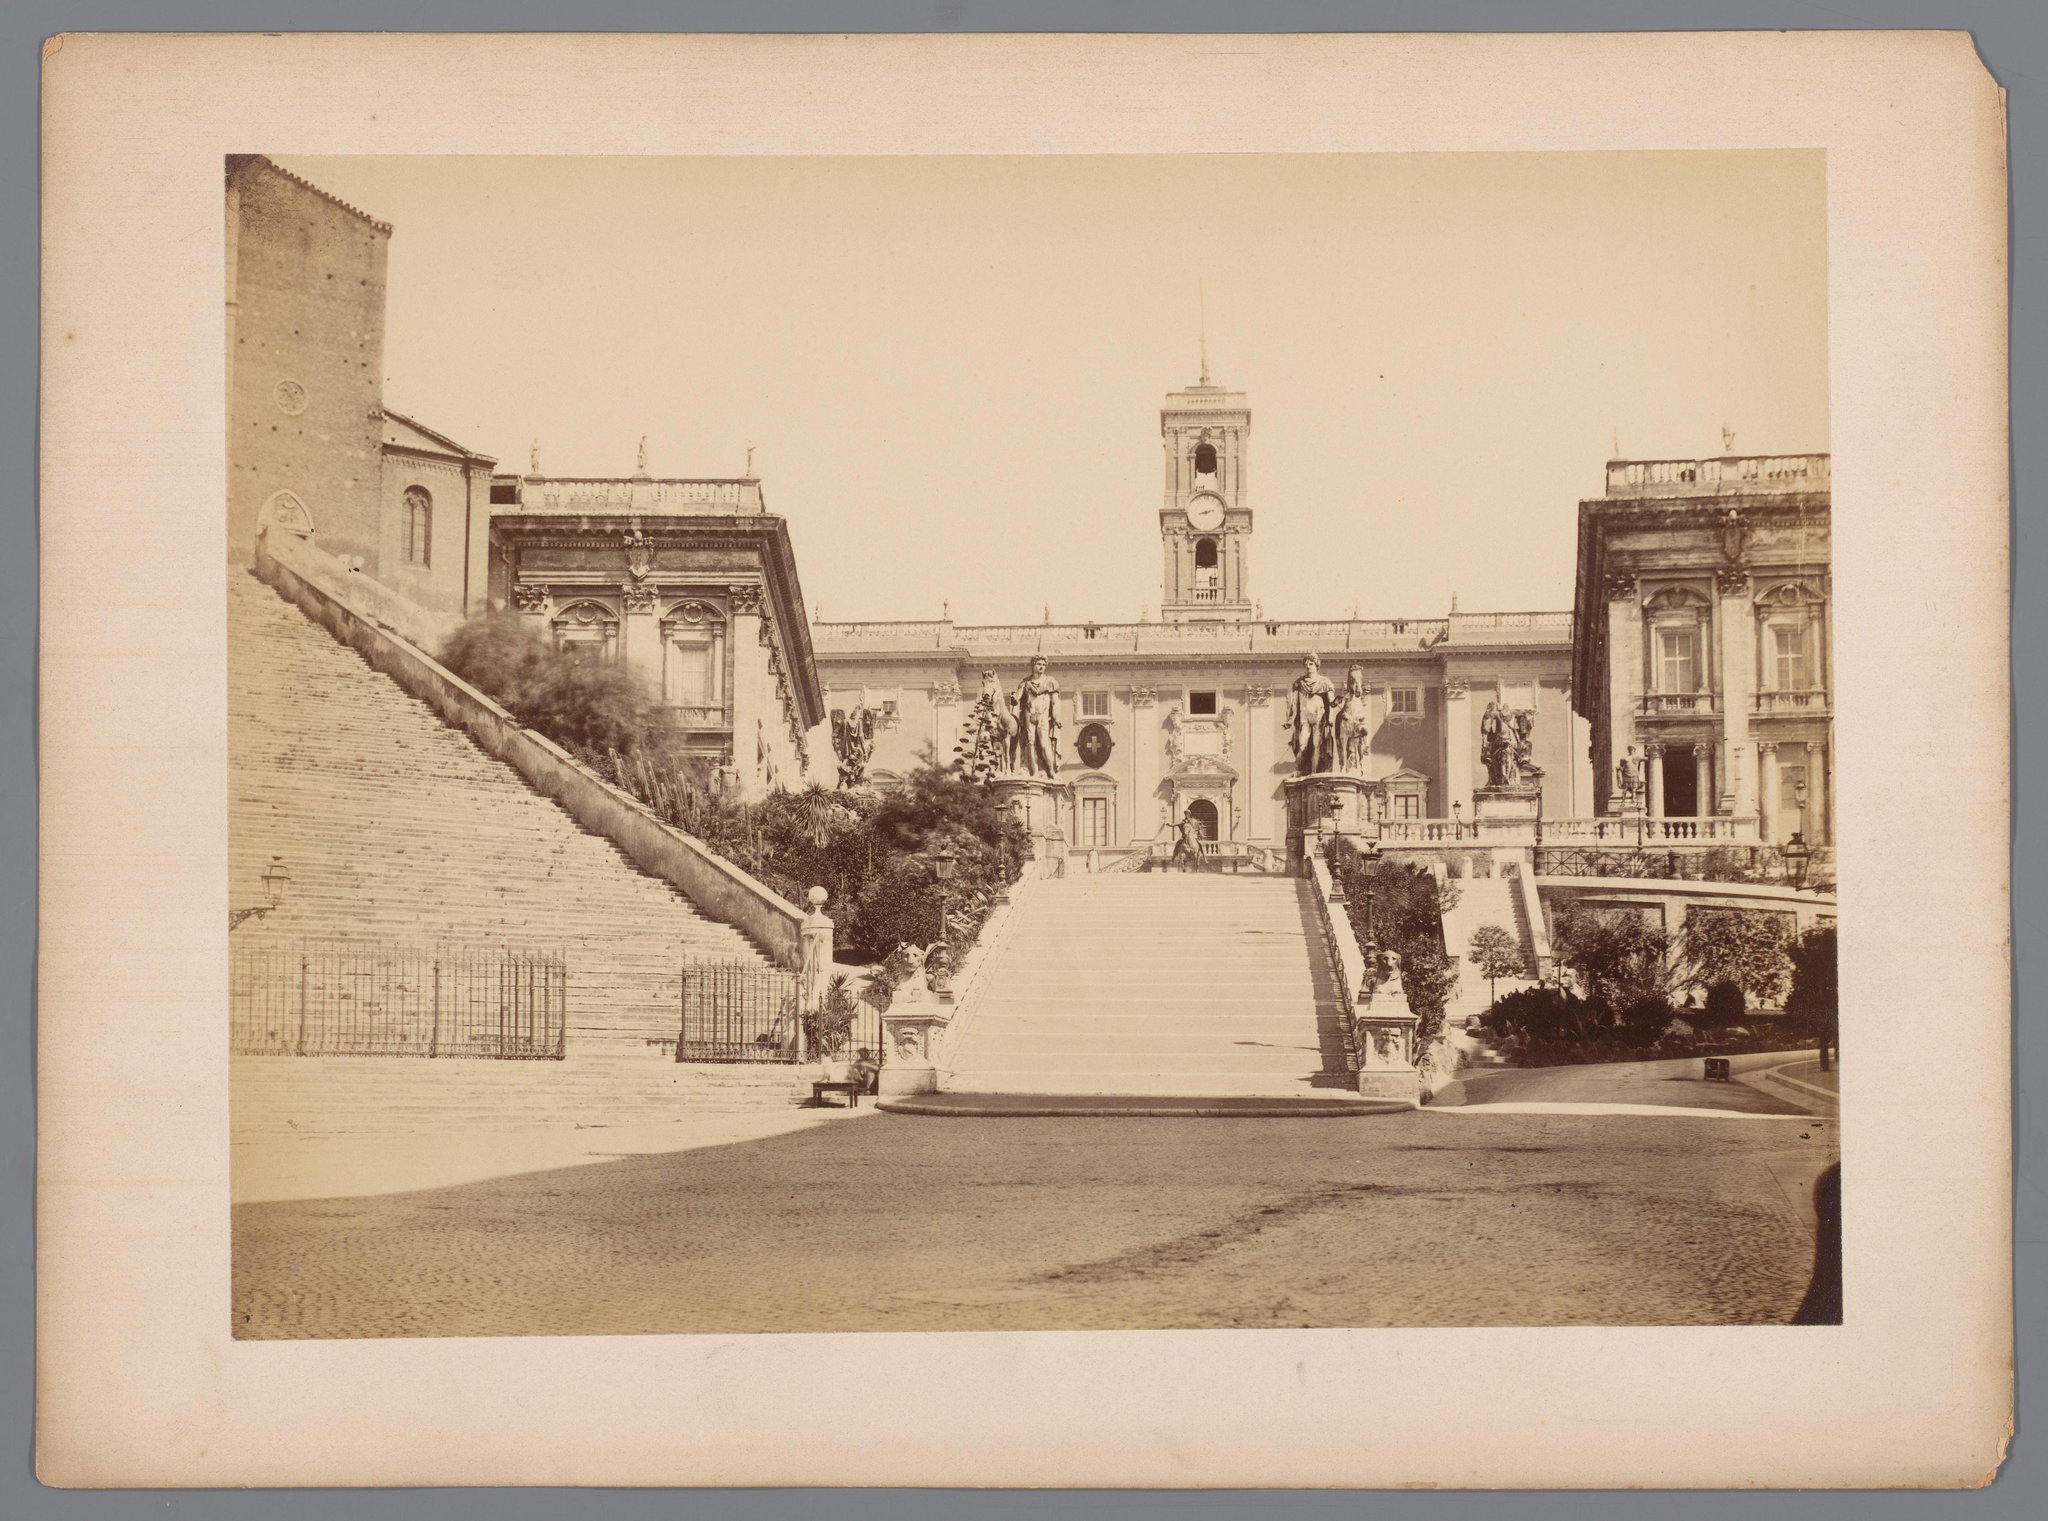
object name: photograph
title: Trappen naar het Capitool te Rome, Italië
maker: Anonymous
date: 1851-1900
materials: cardboard, paper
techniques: albumen print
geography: rome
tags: flight of steps